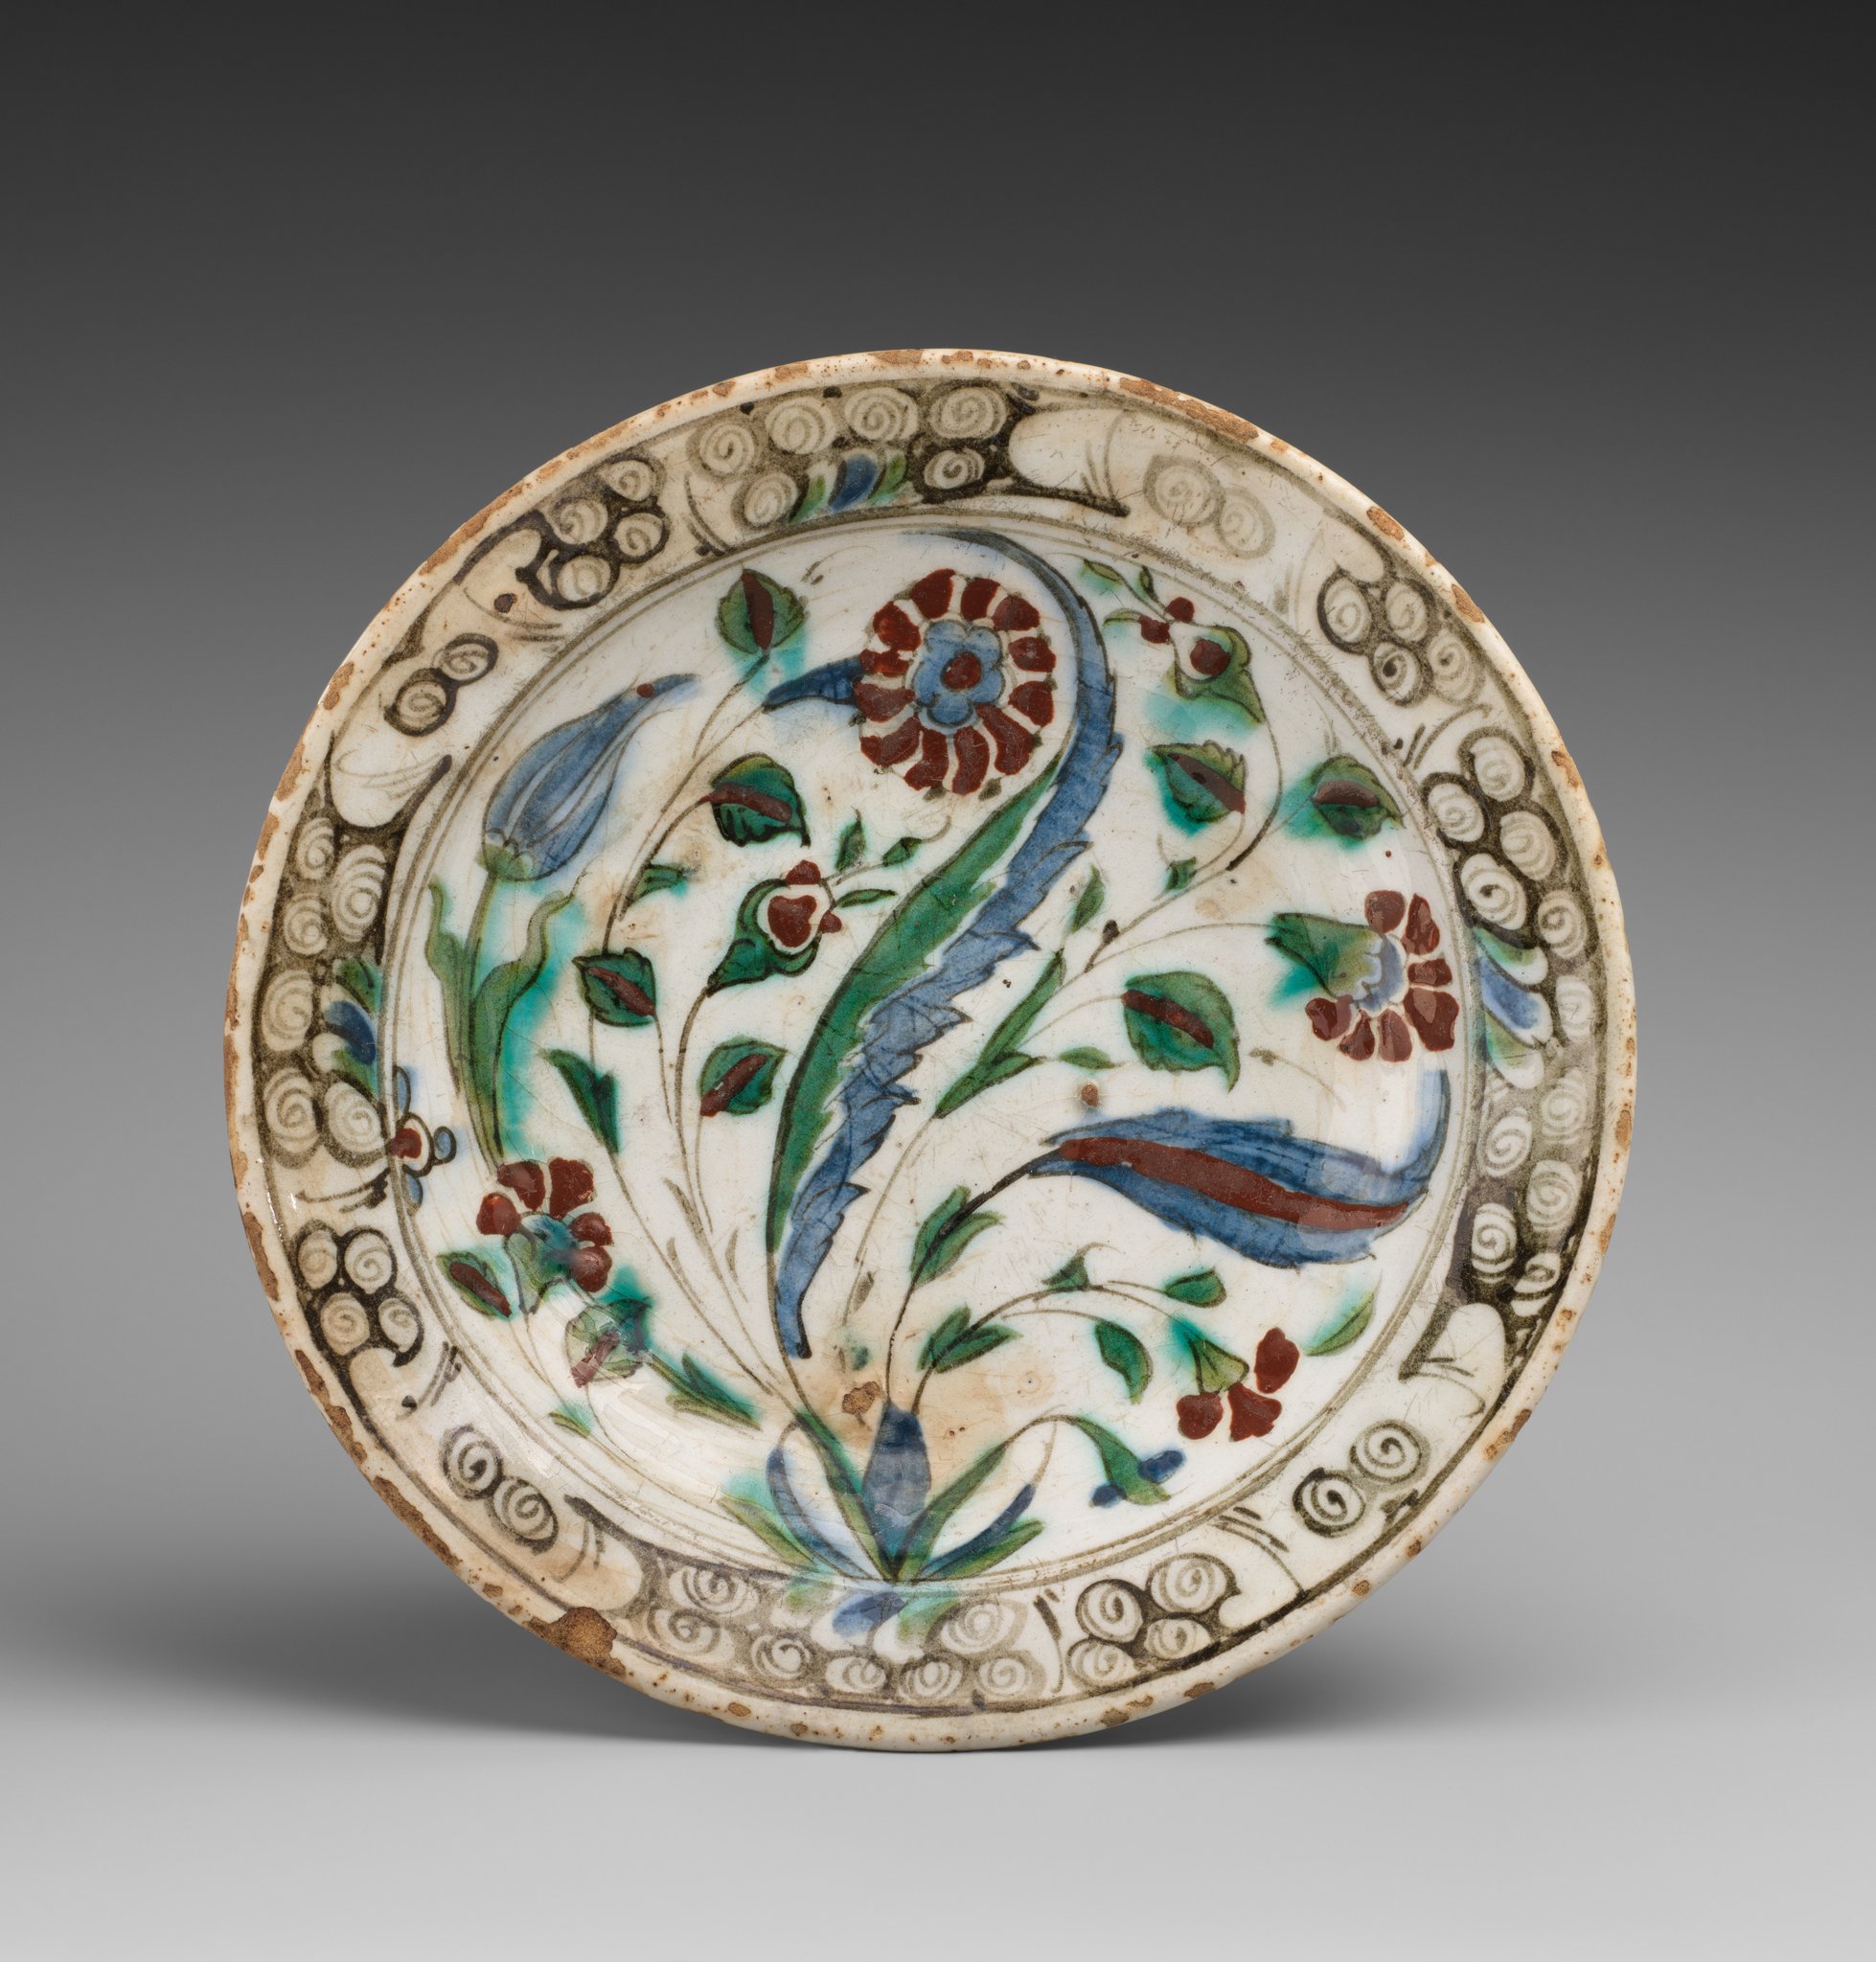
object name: dish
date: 1601-1700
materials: earthenware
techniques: glazing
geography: turkey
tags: flowers